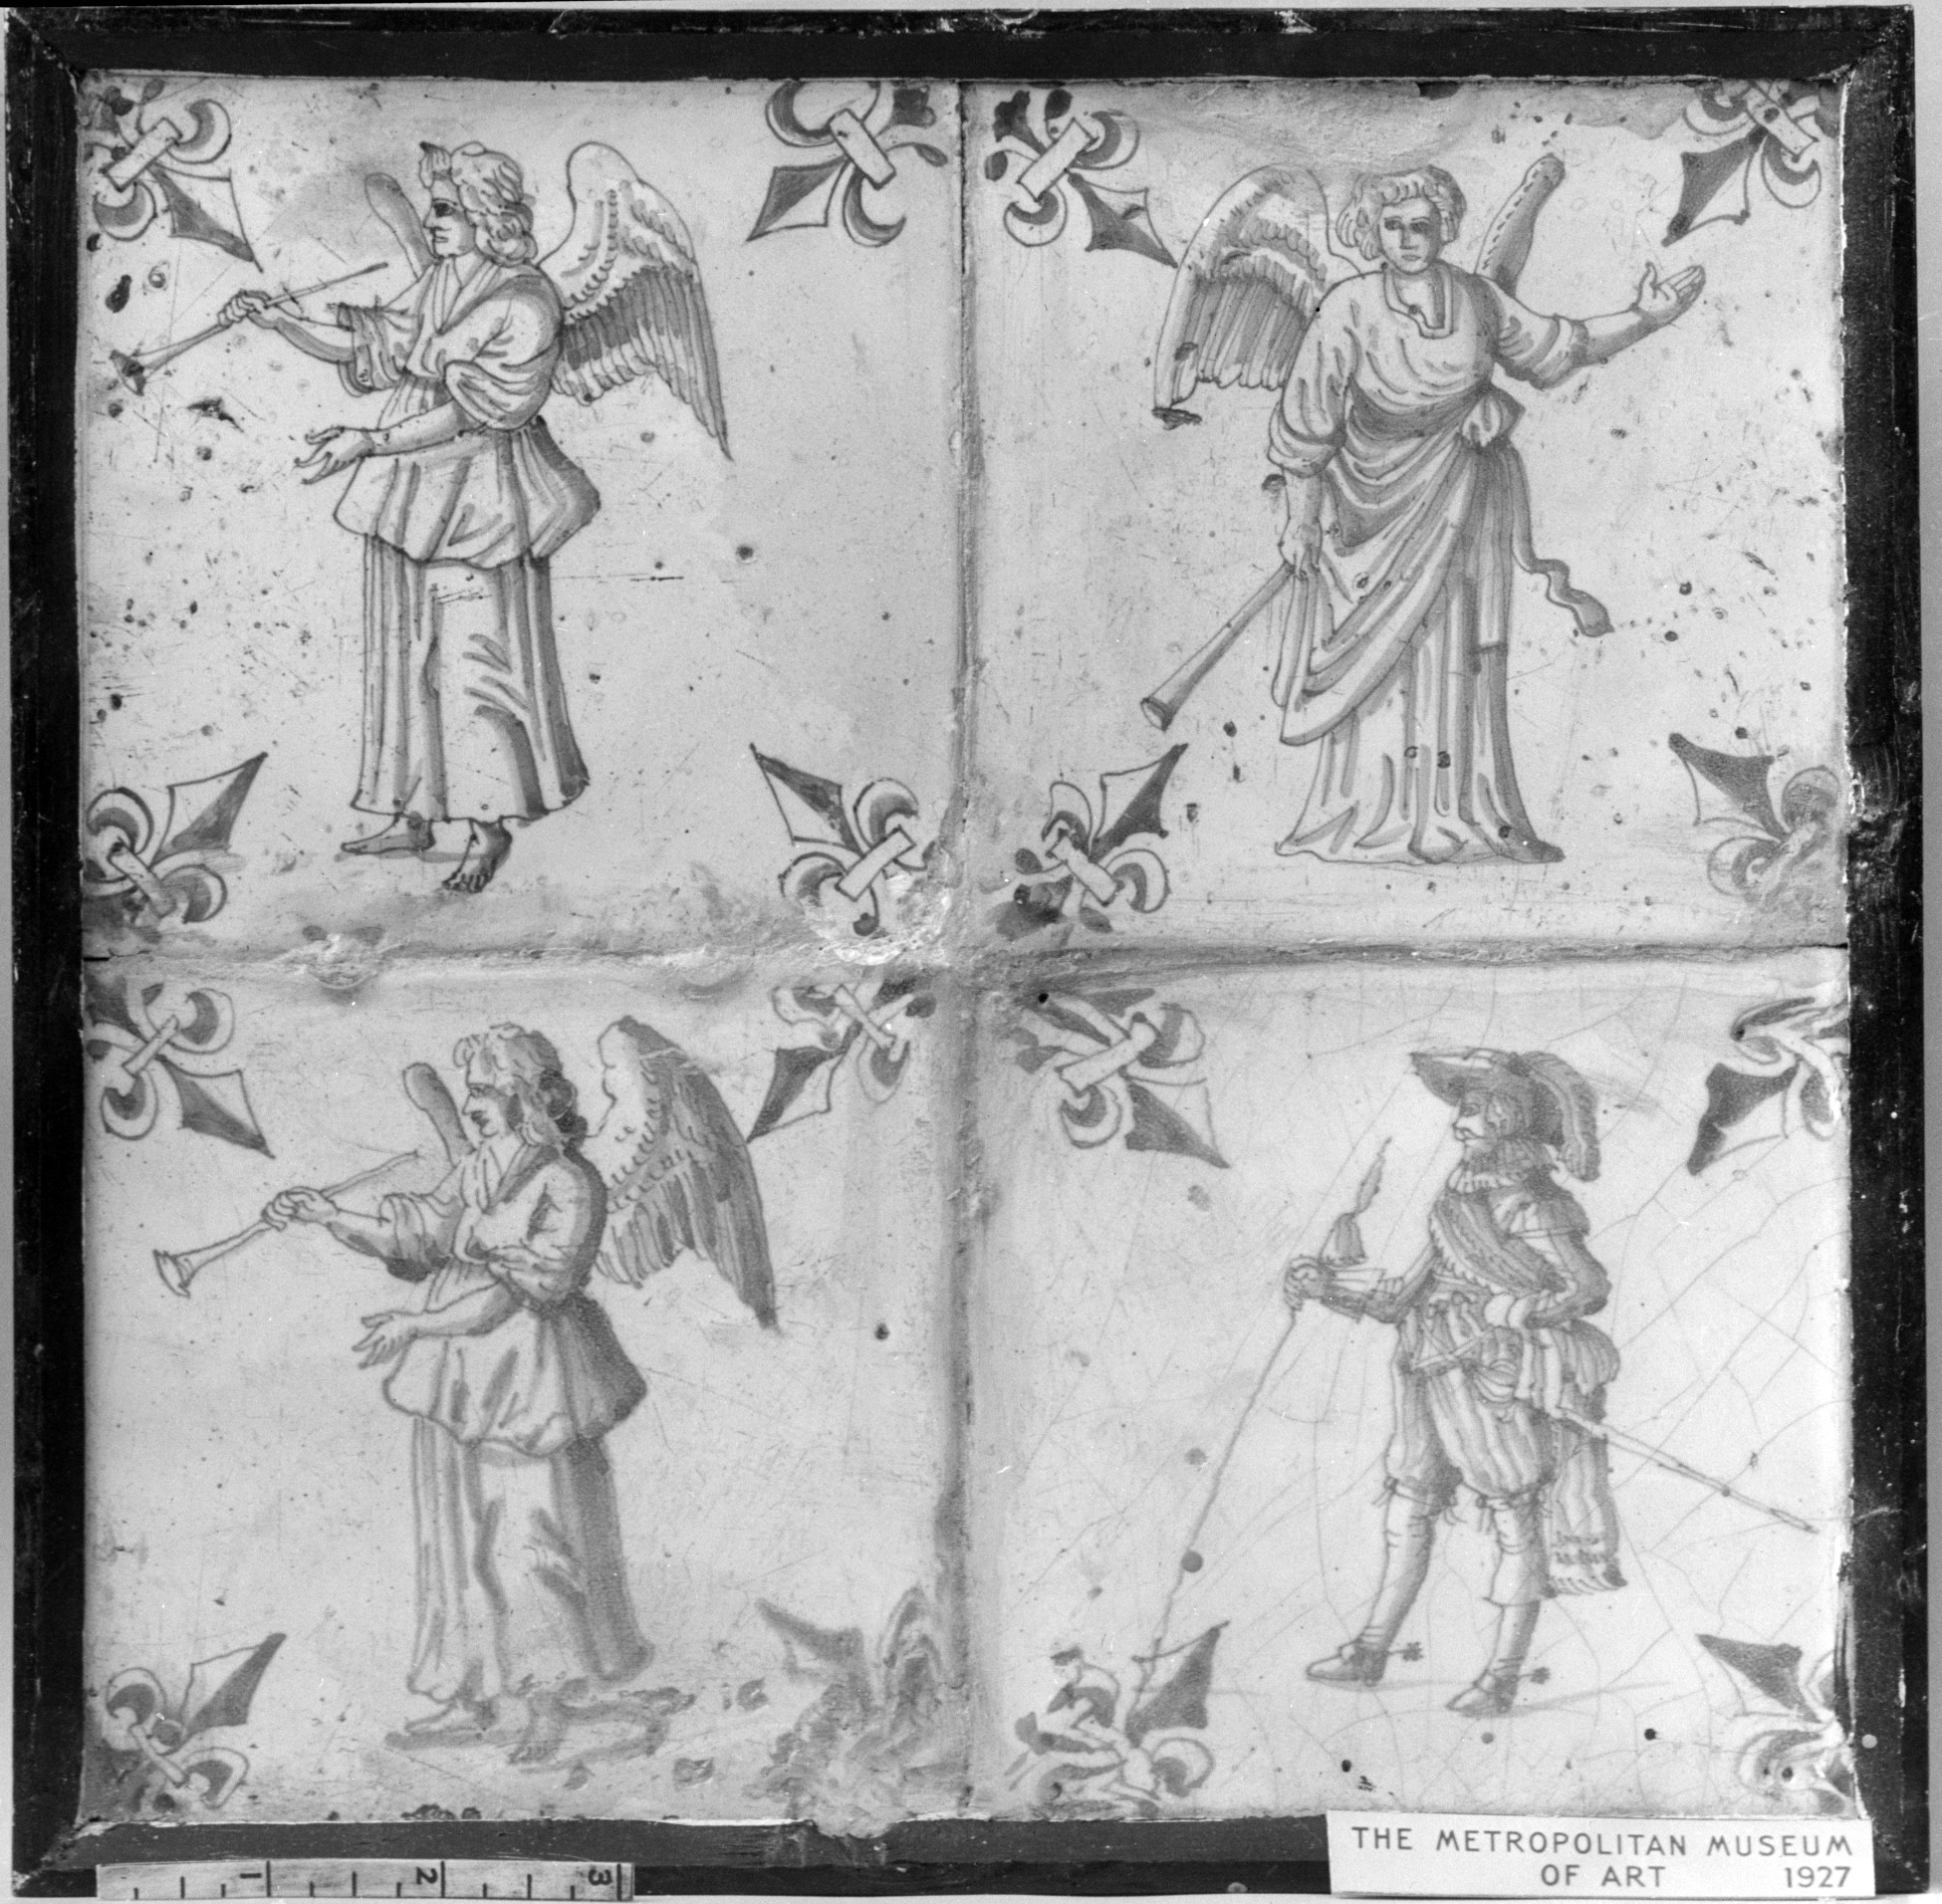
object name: tile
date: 1640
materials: earthenware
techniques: glazing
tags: men,horns,angels